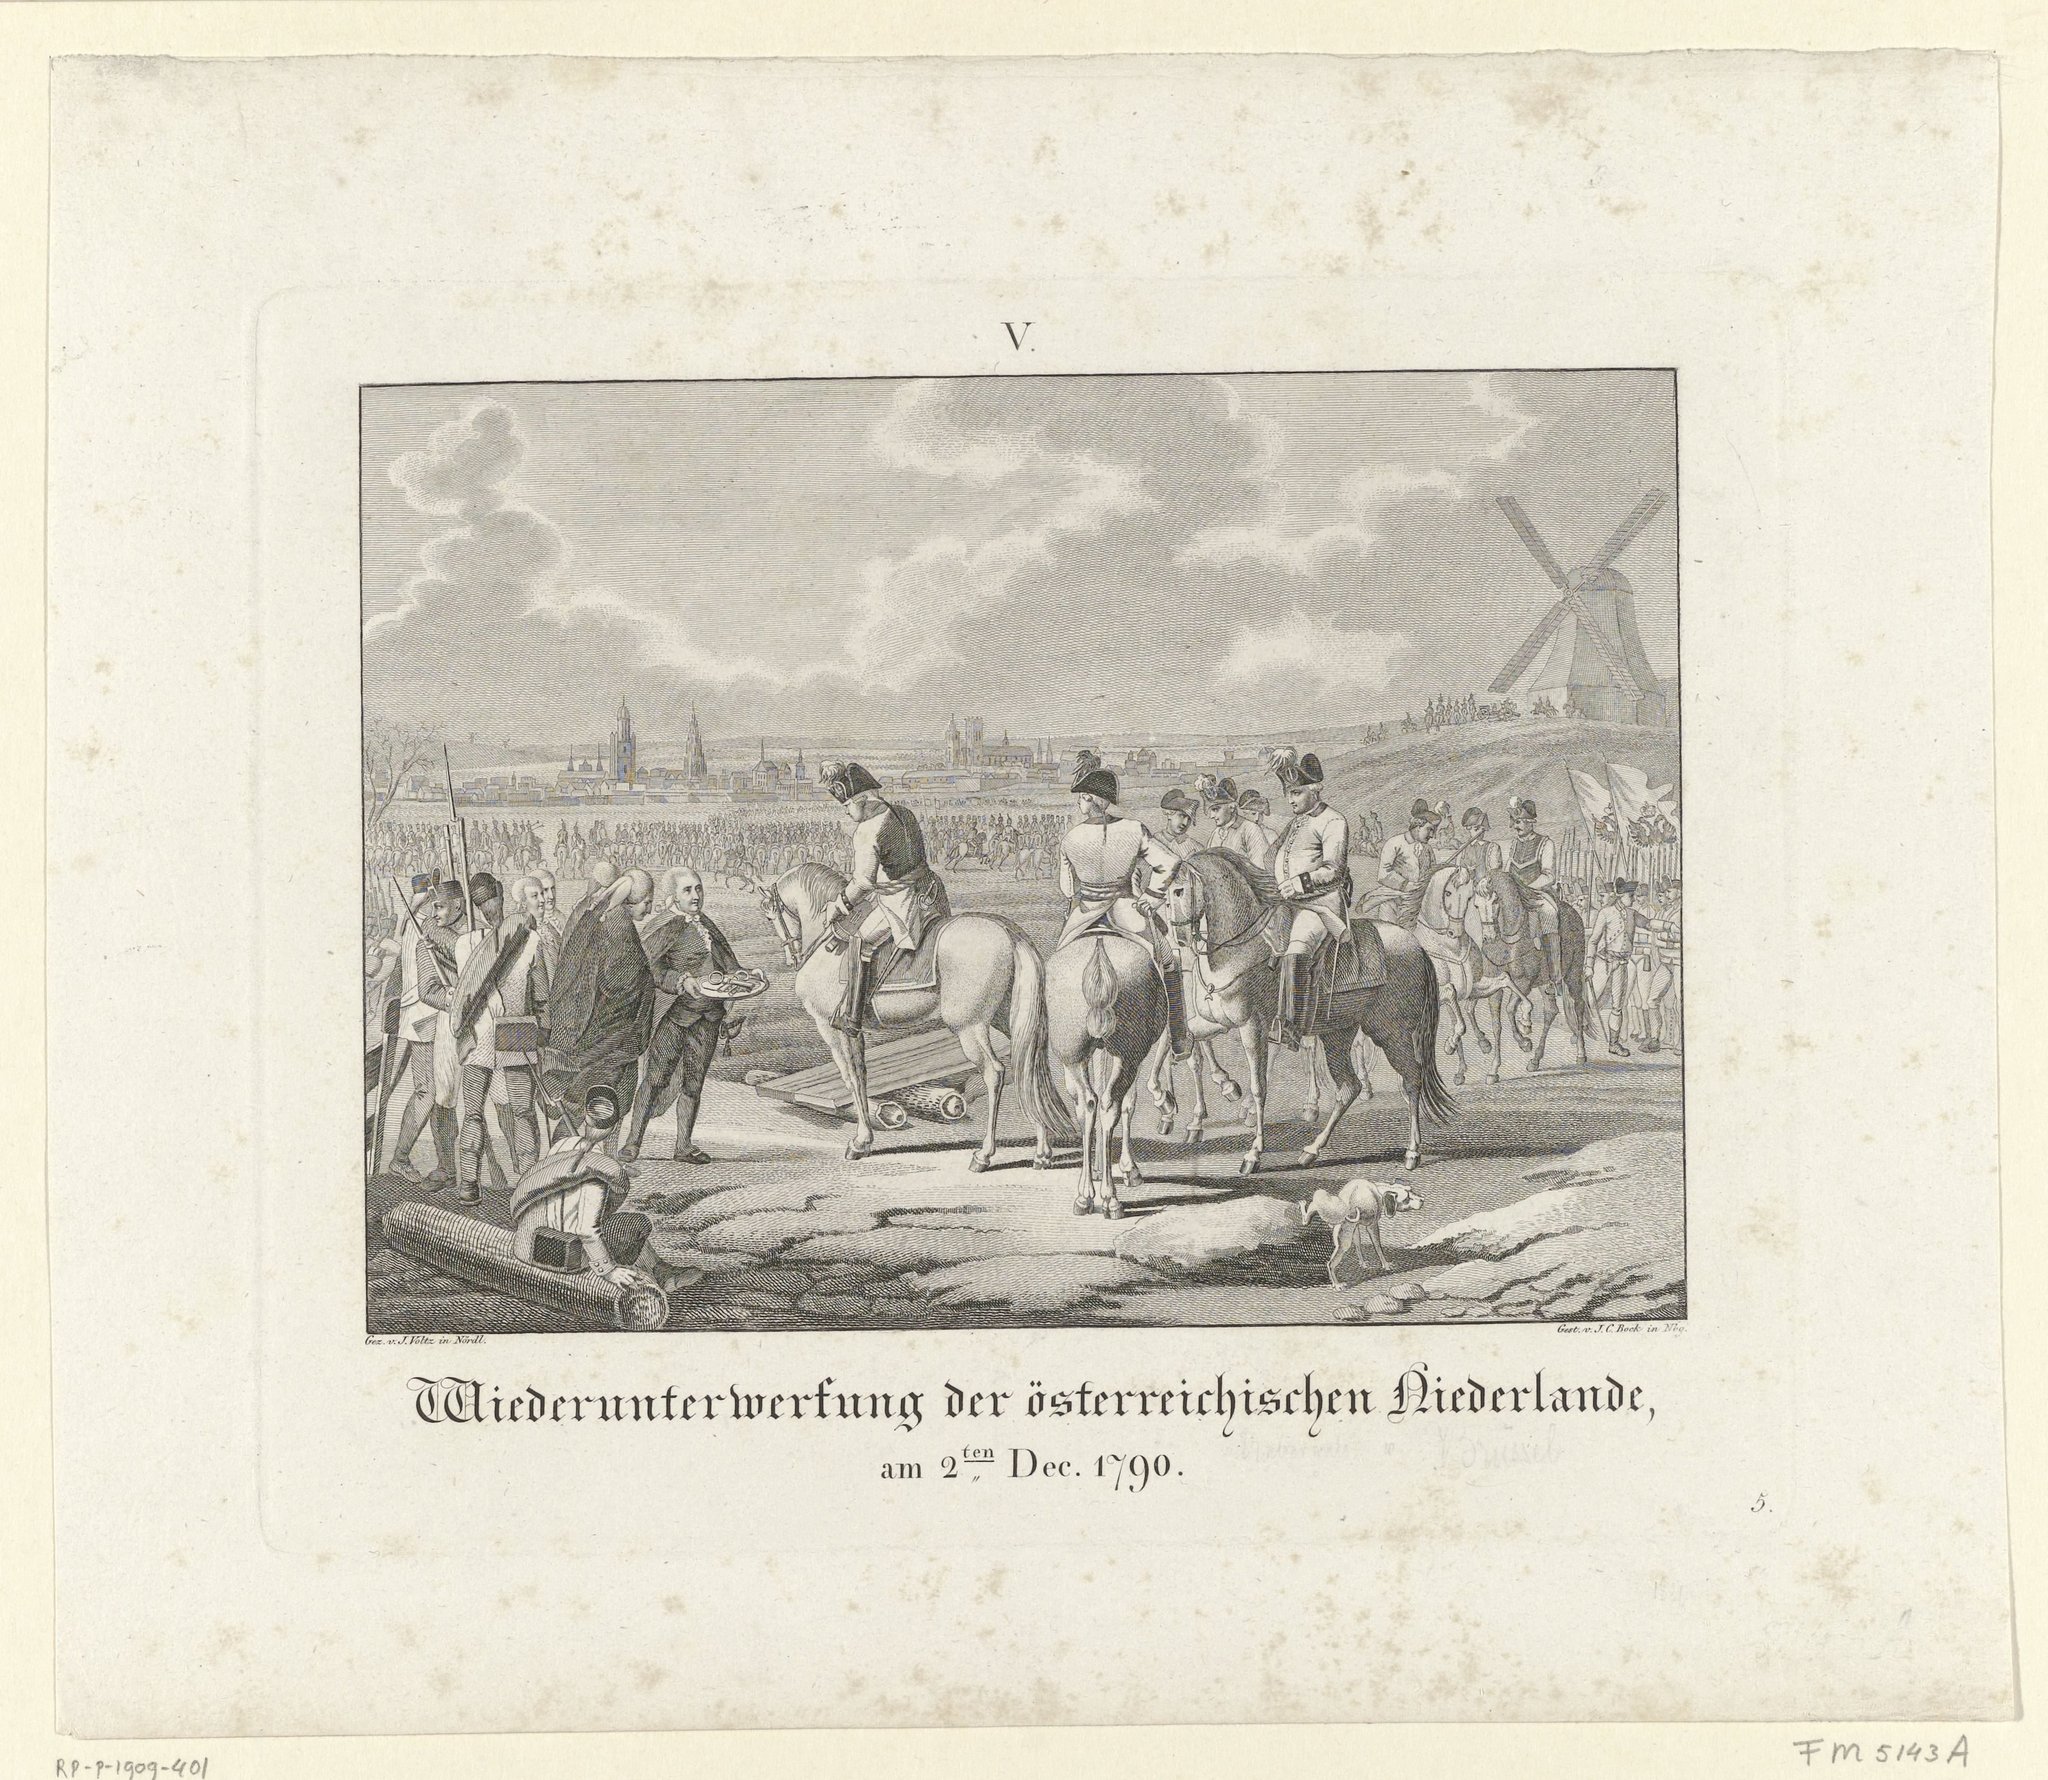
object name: print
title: Overgave van Brugge aan de Oostenrijkse troepen, 1790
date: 1800-1806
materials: paper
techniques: engraving, etching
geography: nördlingen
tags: surrender of keys, bruges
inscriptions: collector's mark: Lugt 2228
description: Overgave van de stad en Staten van Brugge aan de Oostenrijkse troepen, 2 december 1790. Vertegenwoordigers van de stad bieden de Oostenrijkse bevelhebbers de sleutels van de stad aan. Op de achtergrond de stad Brugge. Genummerd bovenaan: V en rechtsonder: 5.